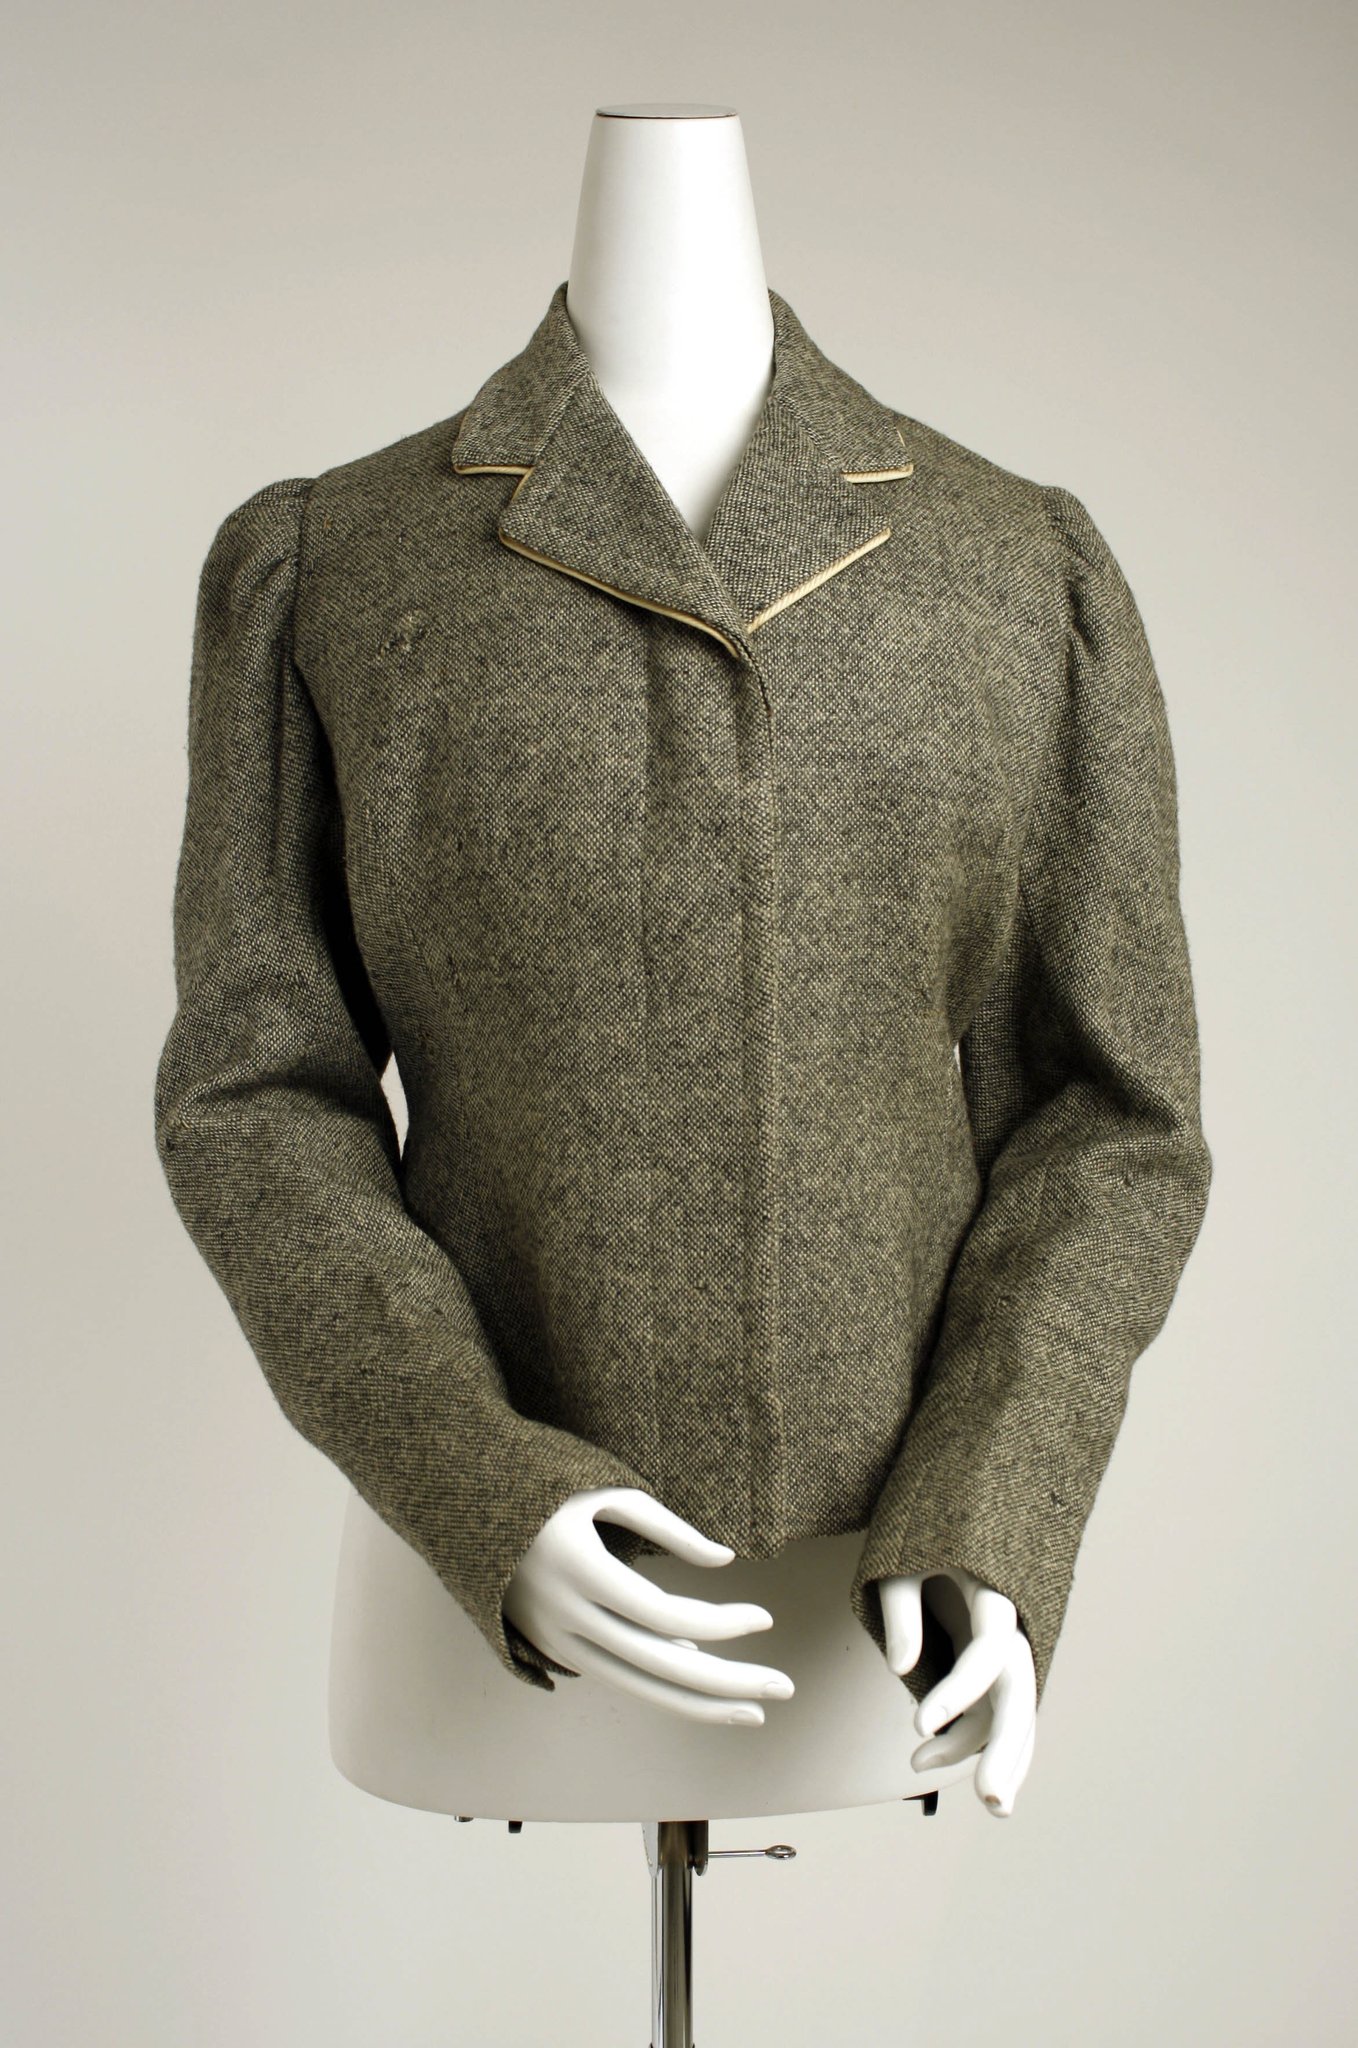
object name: jacket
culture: american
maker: haas brothers importers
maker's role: retailer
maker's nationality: american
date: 1899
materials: wool